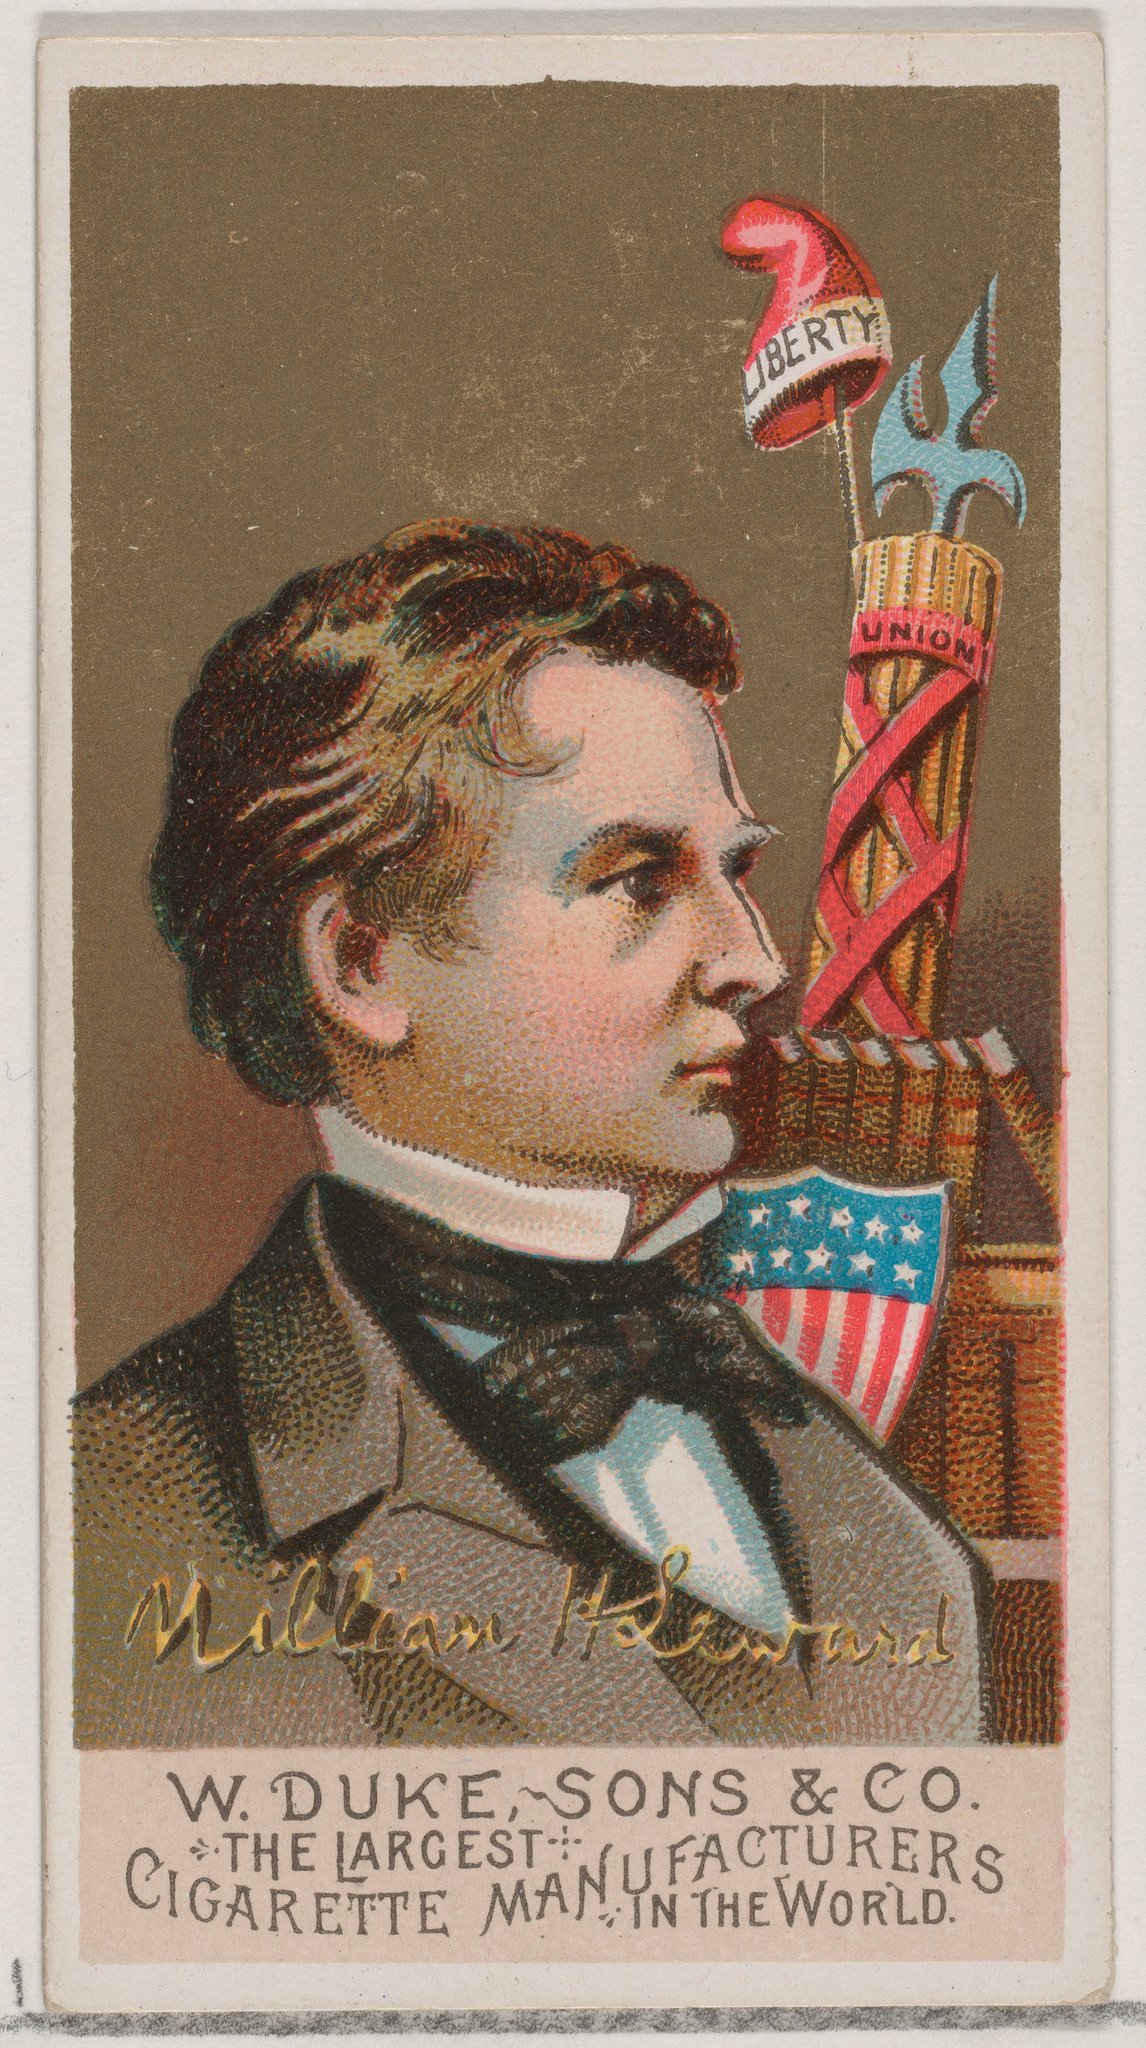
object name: print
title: William H. Seward, from the series Great Americans (N76) for Duke brand cigarettes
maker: w. duke, sons & co.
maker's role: publisher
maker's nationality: american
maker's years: 1870-1920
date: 1888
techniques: color lithograph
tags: men